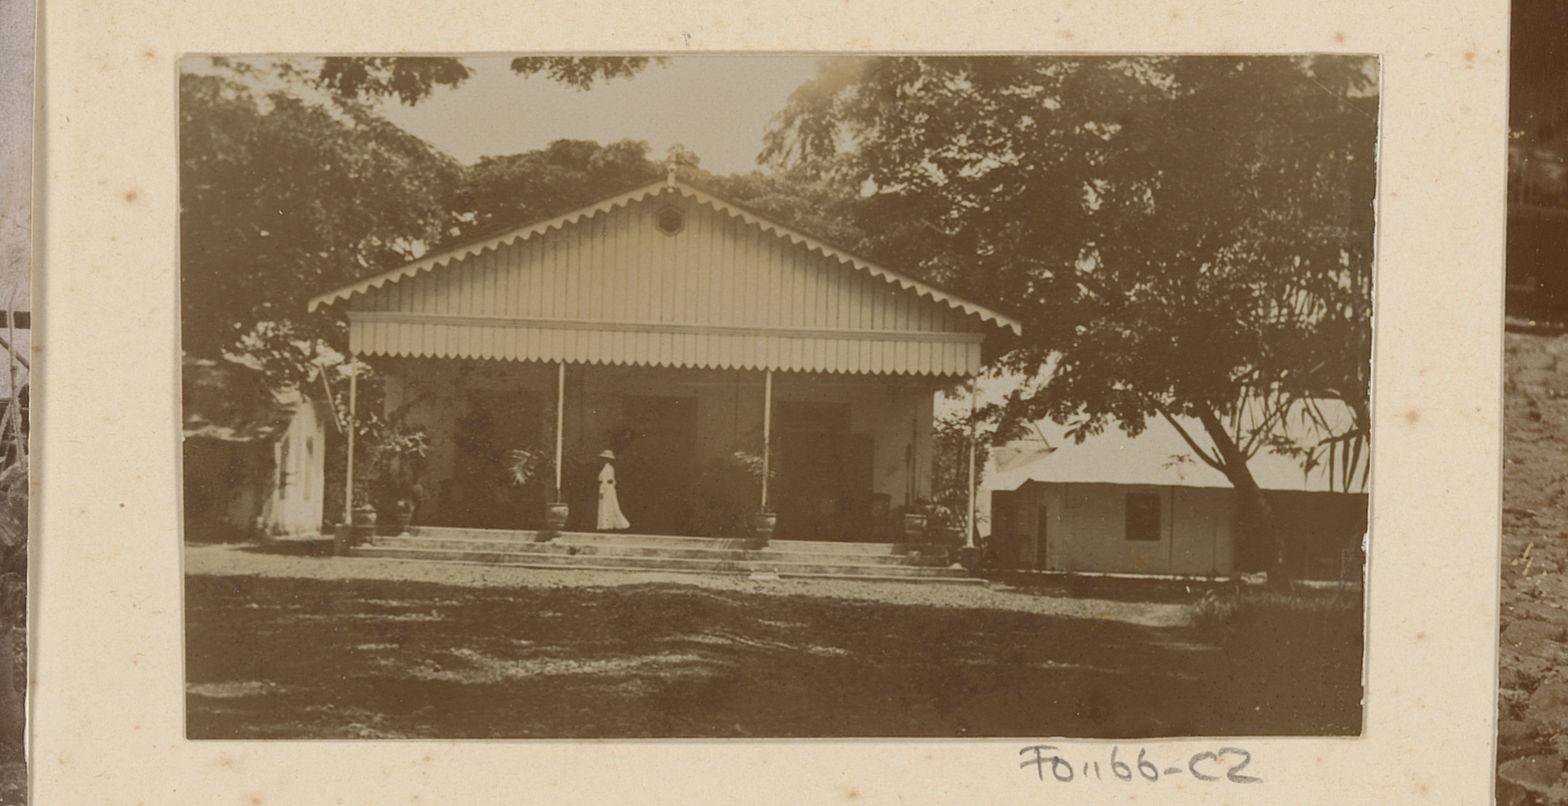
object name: album leaf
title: Vrouw op een veranda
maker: Anonymous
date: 1880-1910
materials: photographic support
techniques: gelatin silver print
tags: adult woman, historical persons, loggia, verandah, porch, dutch east indies, the